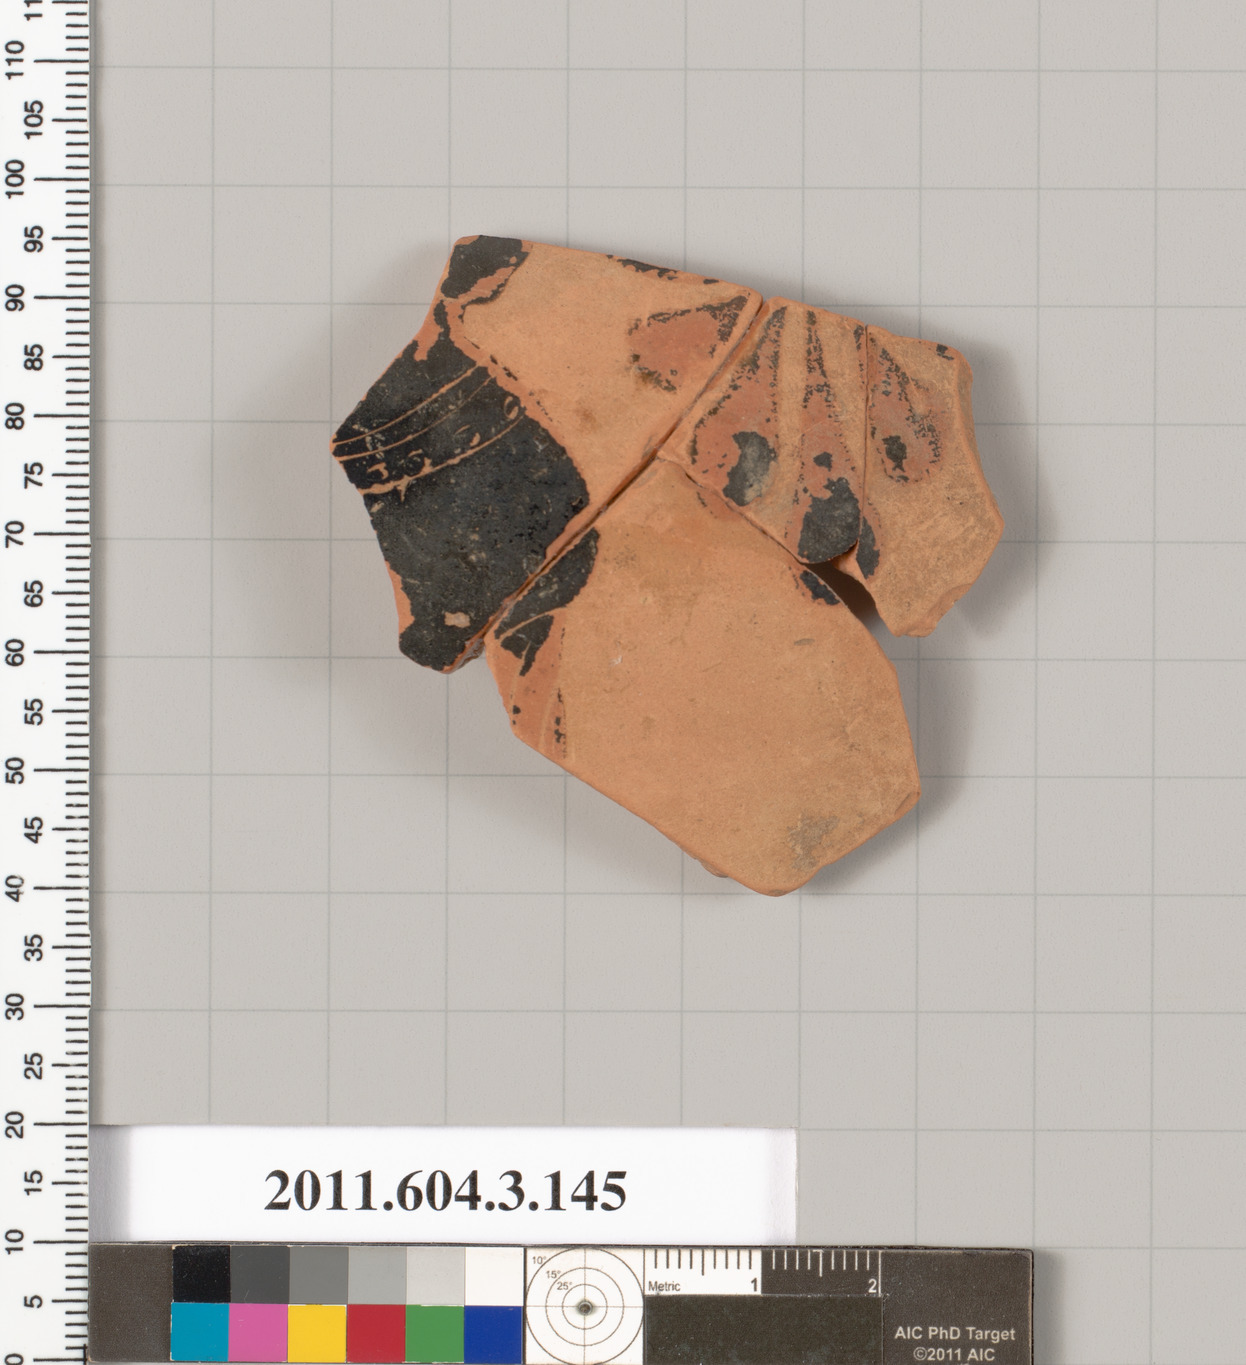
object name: amphora fragment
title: Terracotta fragment of an amphora (jar)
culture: greek, attic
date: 500-468 BCE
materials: terracotta